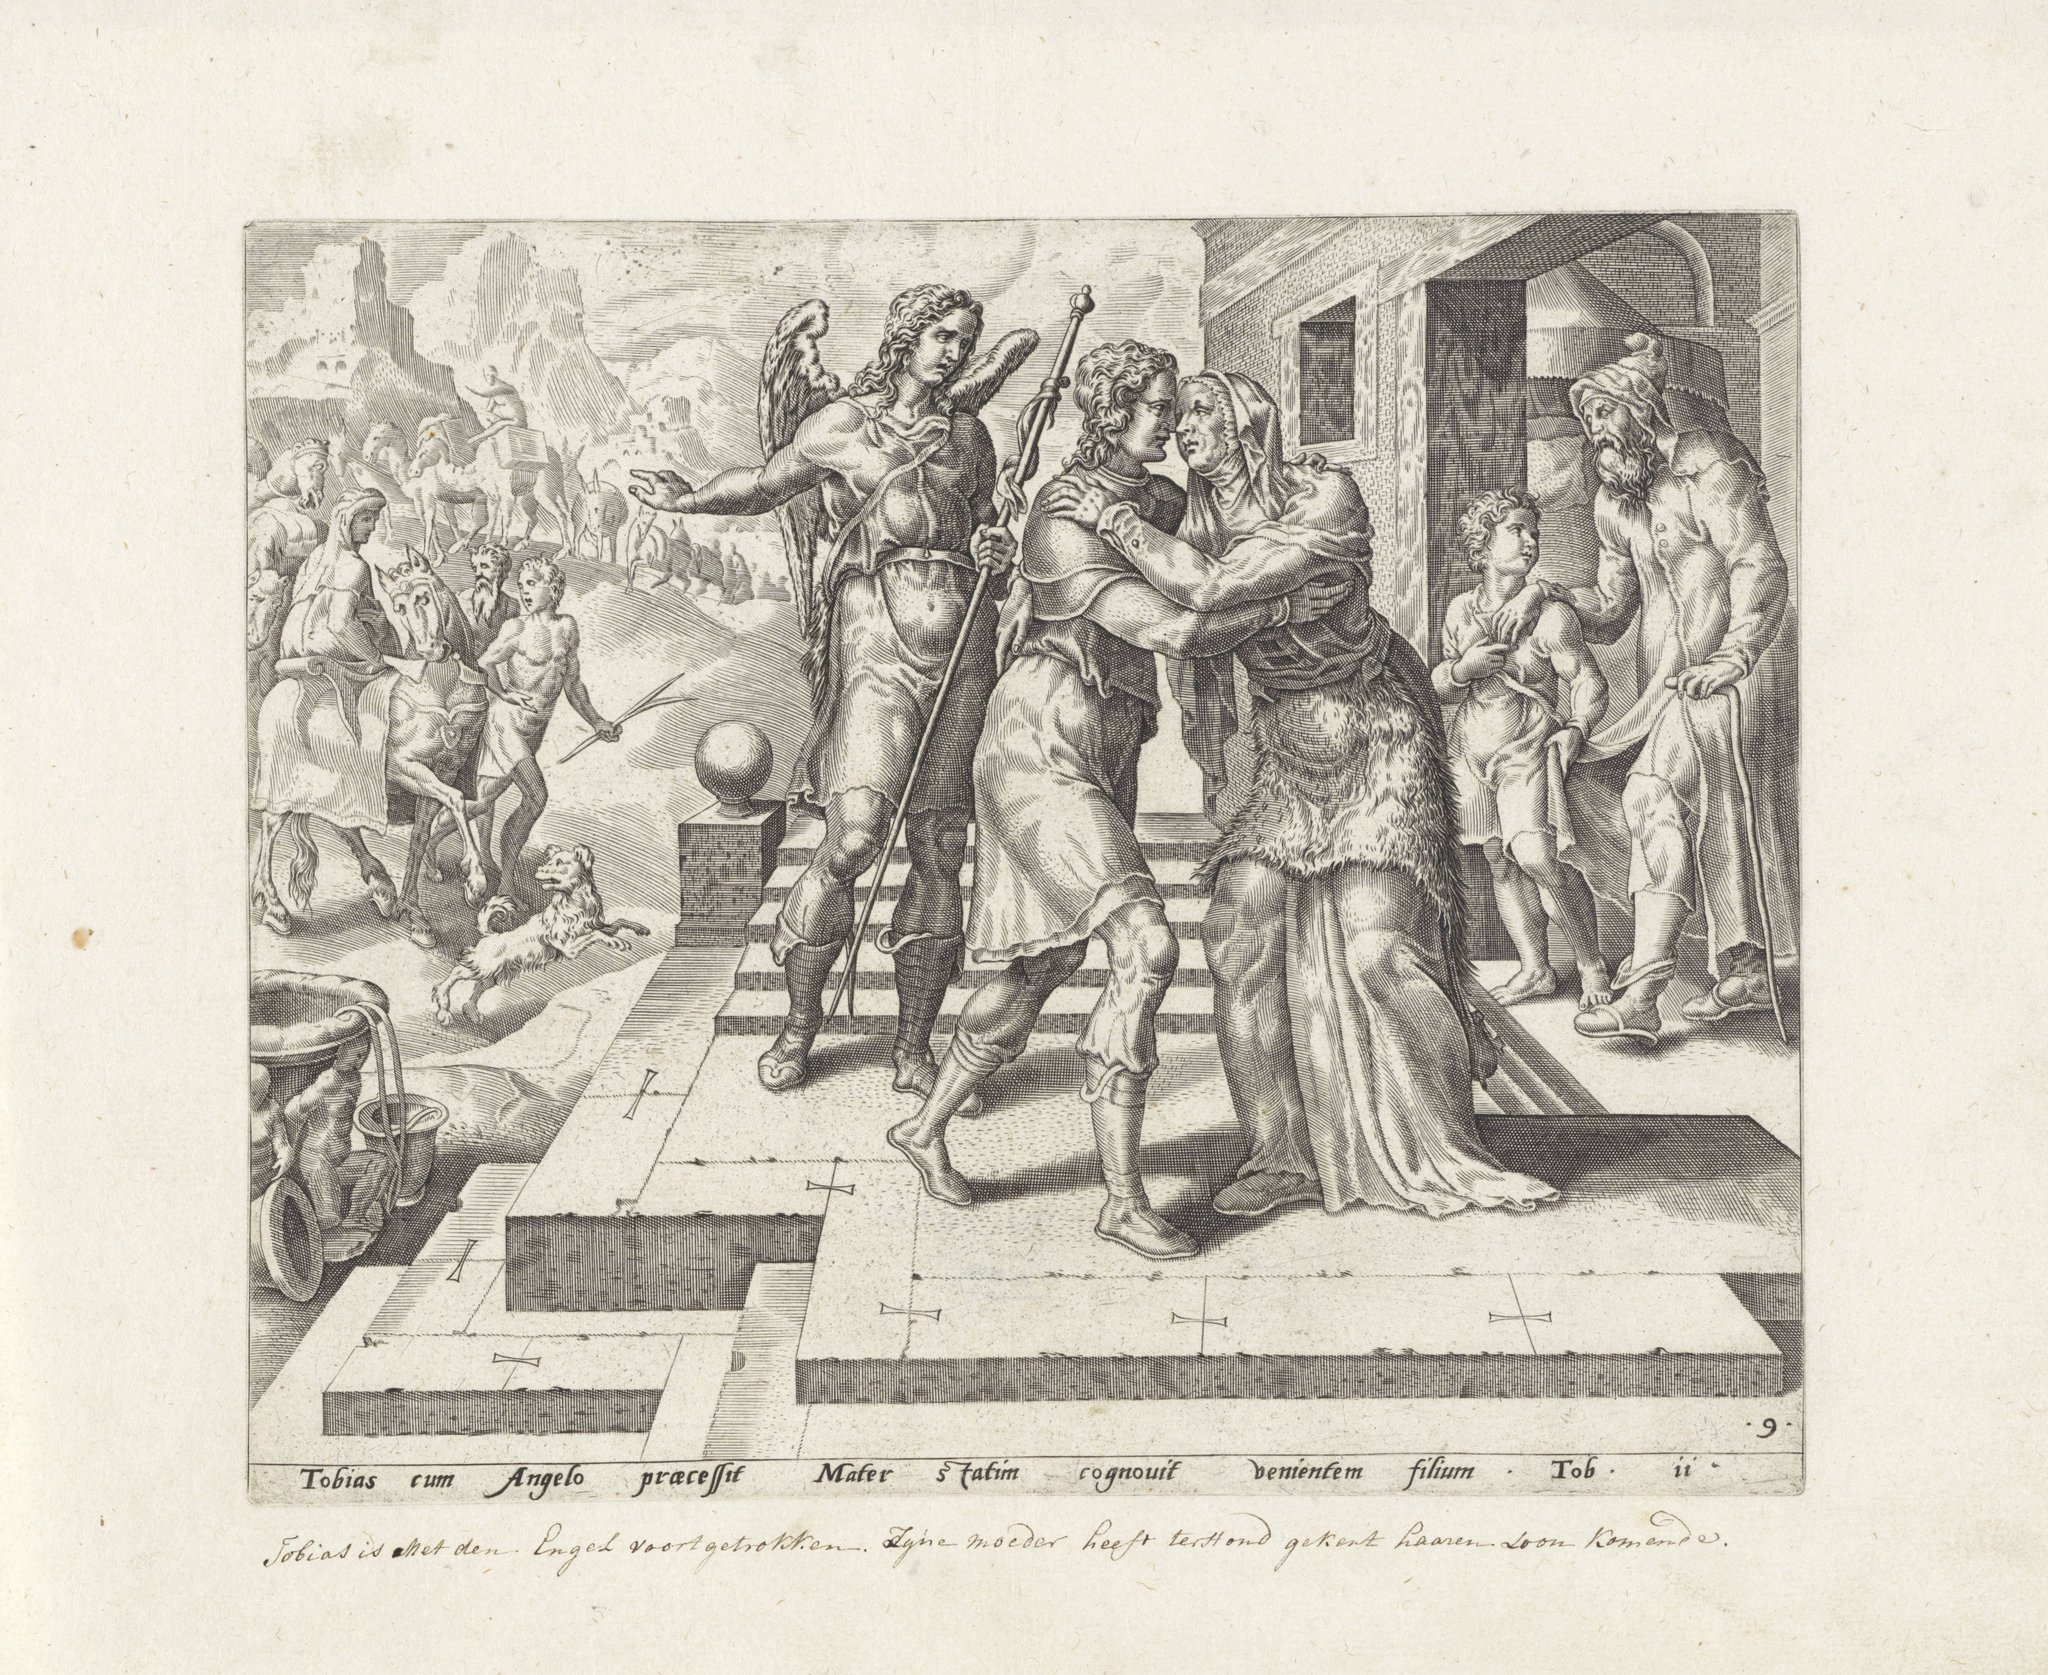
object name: print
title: Terugkeer van Tobias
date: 1556-1633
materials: paper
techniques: engraving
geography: low countries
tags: the meeting of parents and son ~ tobias' return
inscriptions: collector's mark: Lugt 2228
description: Tobias omhelst zijn moeder Anna bij thuiskomst. Achter haar leidt een jongen de blinde Tobit naar buiten. De aartsengel Rafaël wijst in de richting van Sara en de met geschenken bepakte dieren. Onderaan in de marge een éénregelig onderschrift in het Latijn uit Tobit 11.